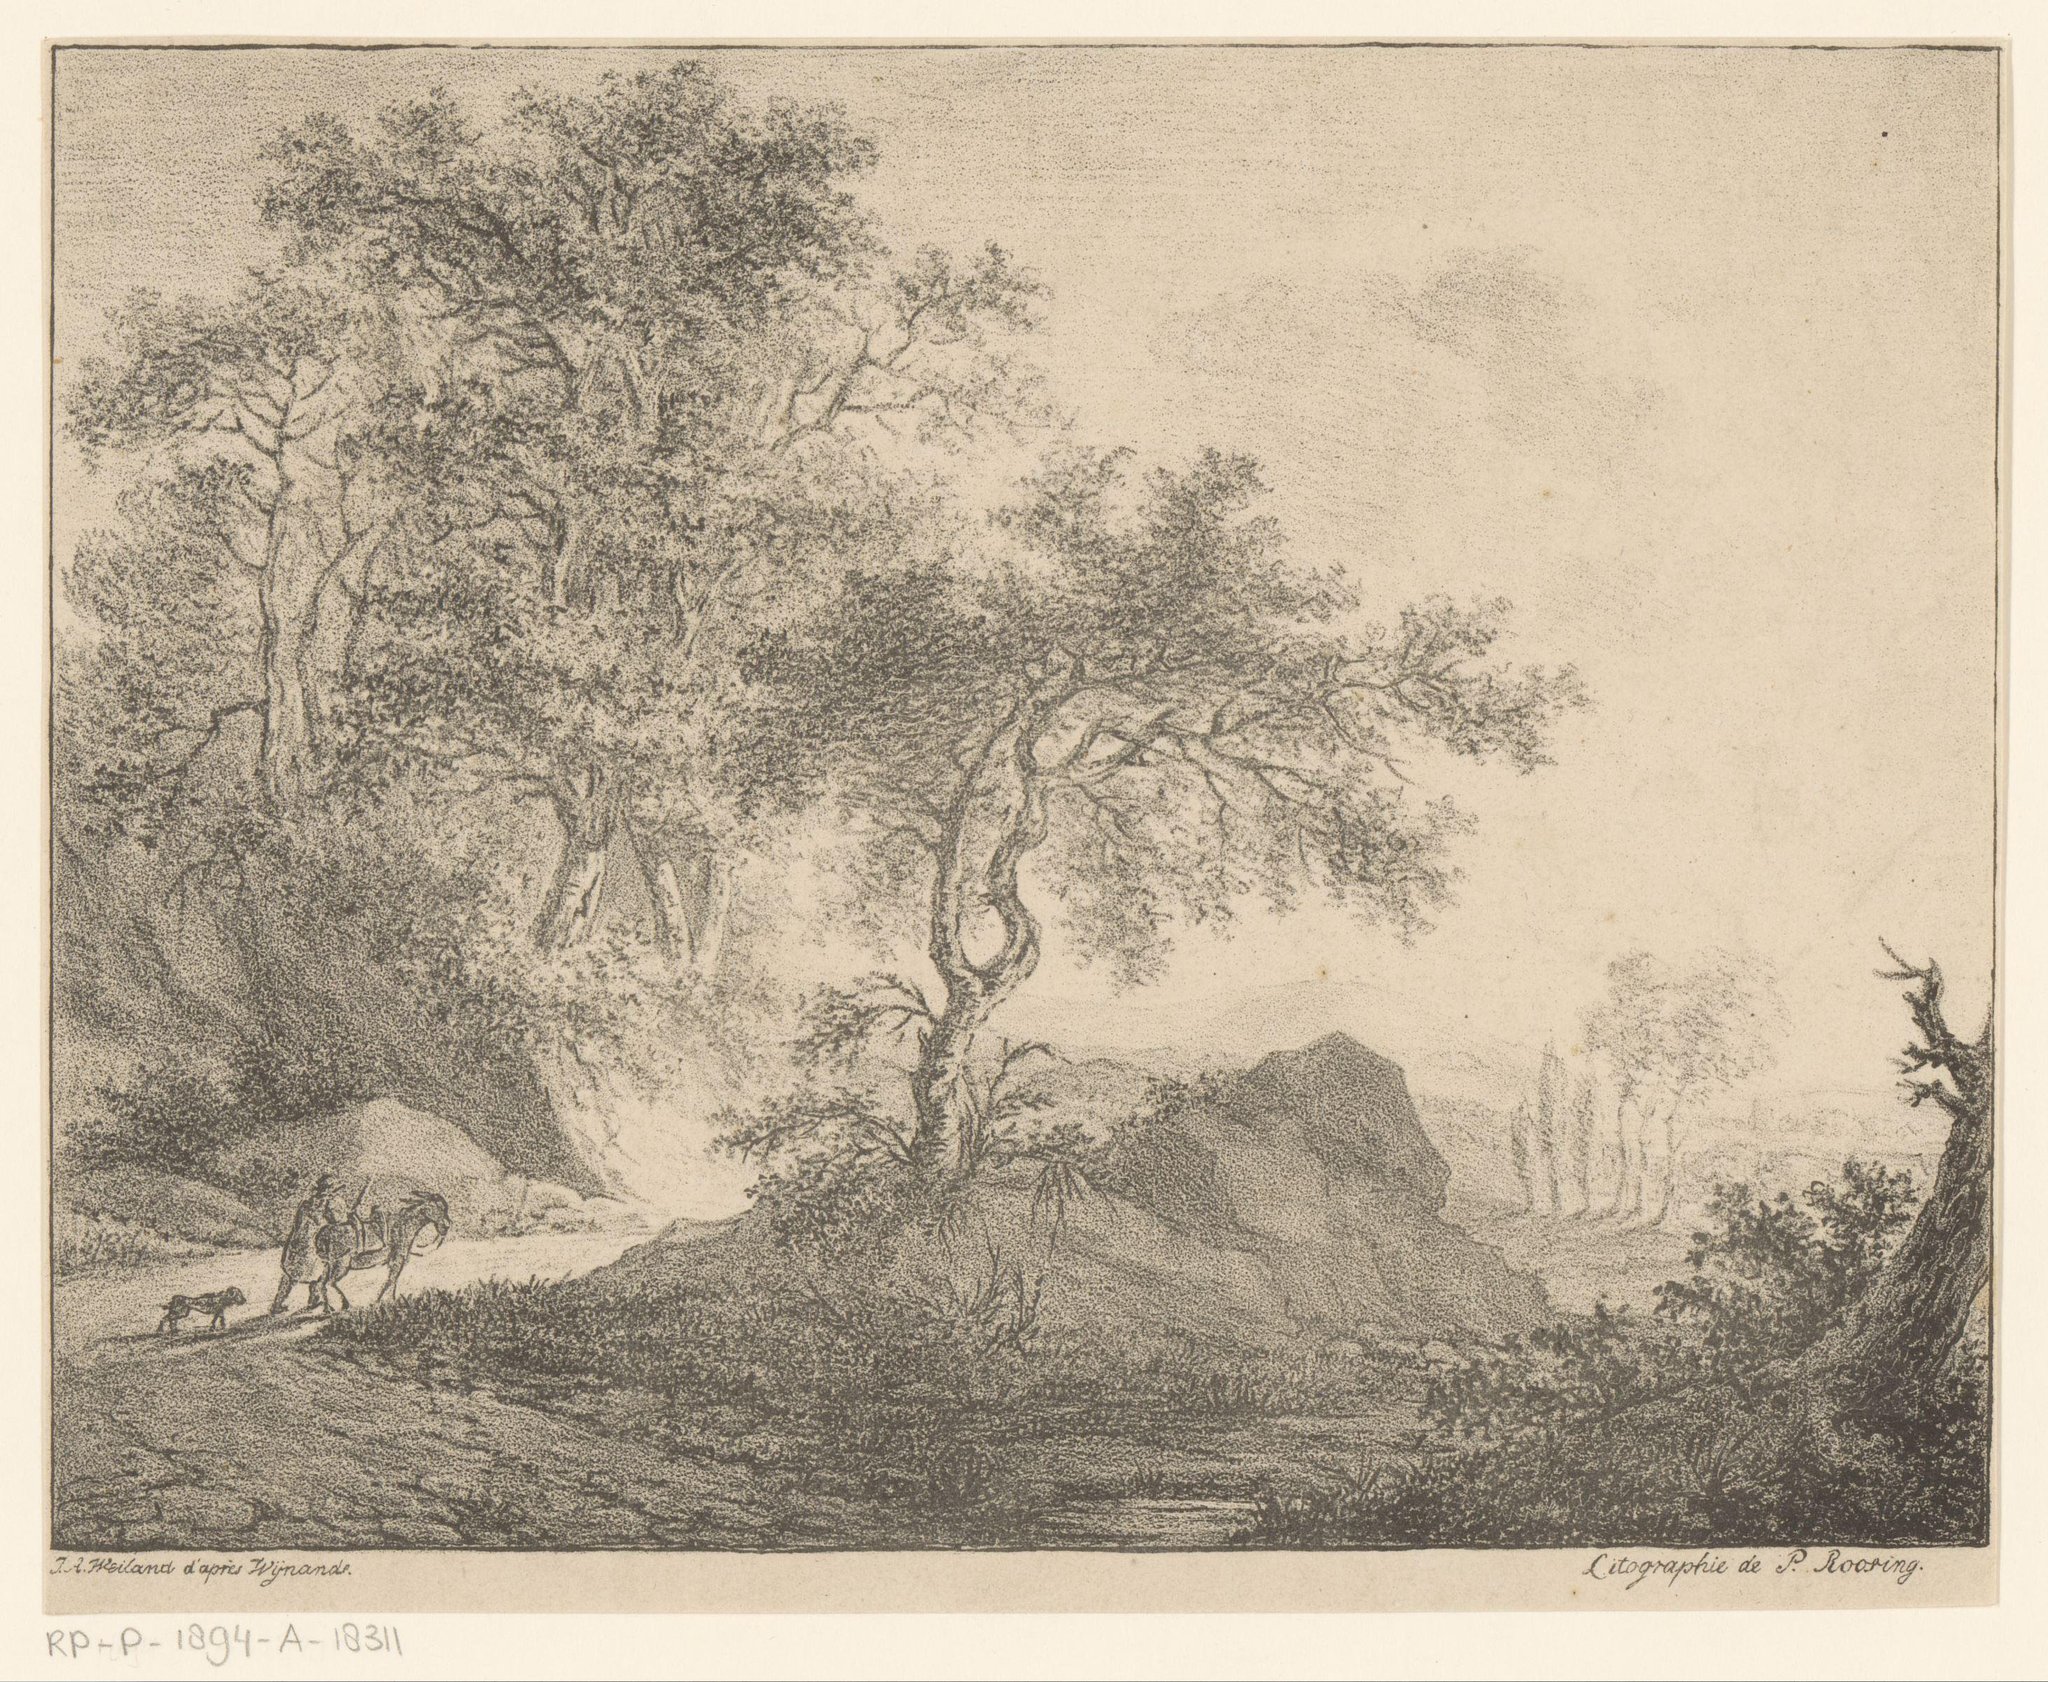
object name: print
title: Ezeldrijver in berglandschap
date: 1809-1839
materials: paper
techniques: lithograph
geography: rotterdam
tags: ass, donkey, landscapes (+ landscape with figures, staffage), dog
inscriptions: collector's mark: Lugt 2228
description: Links drijft een man een ezel voort, gevolgd door een hond.